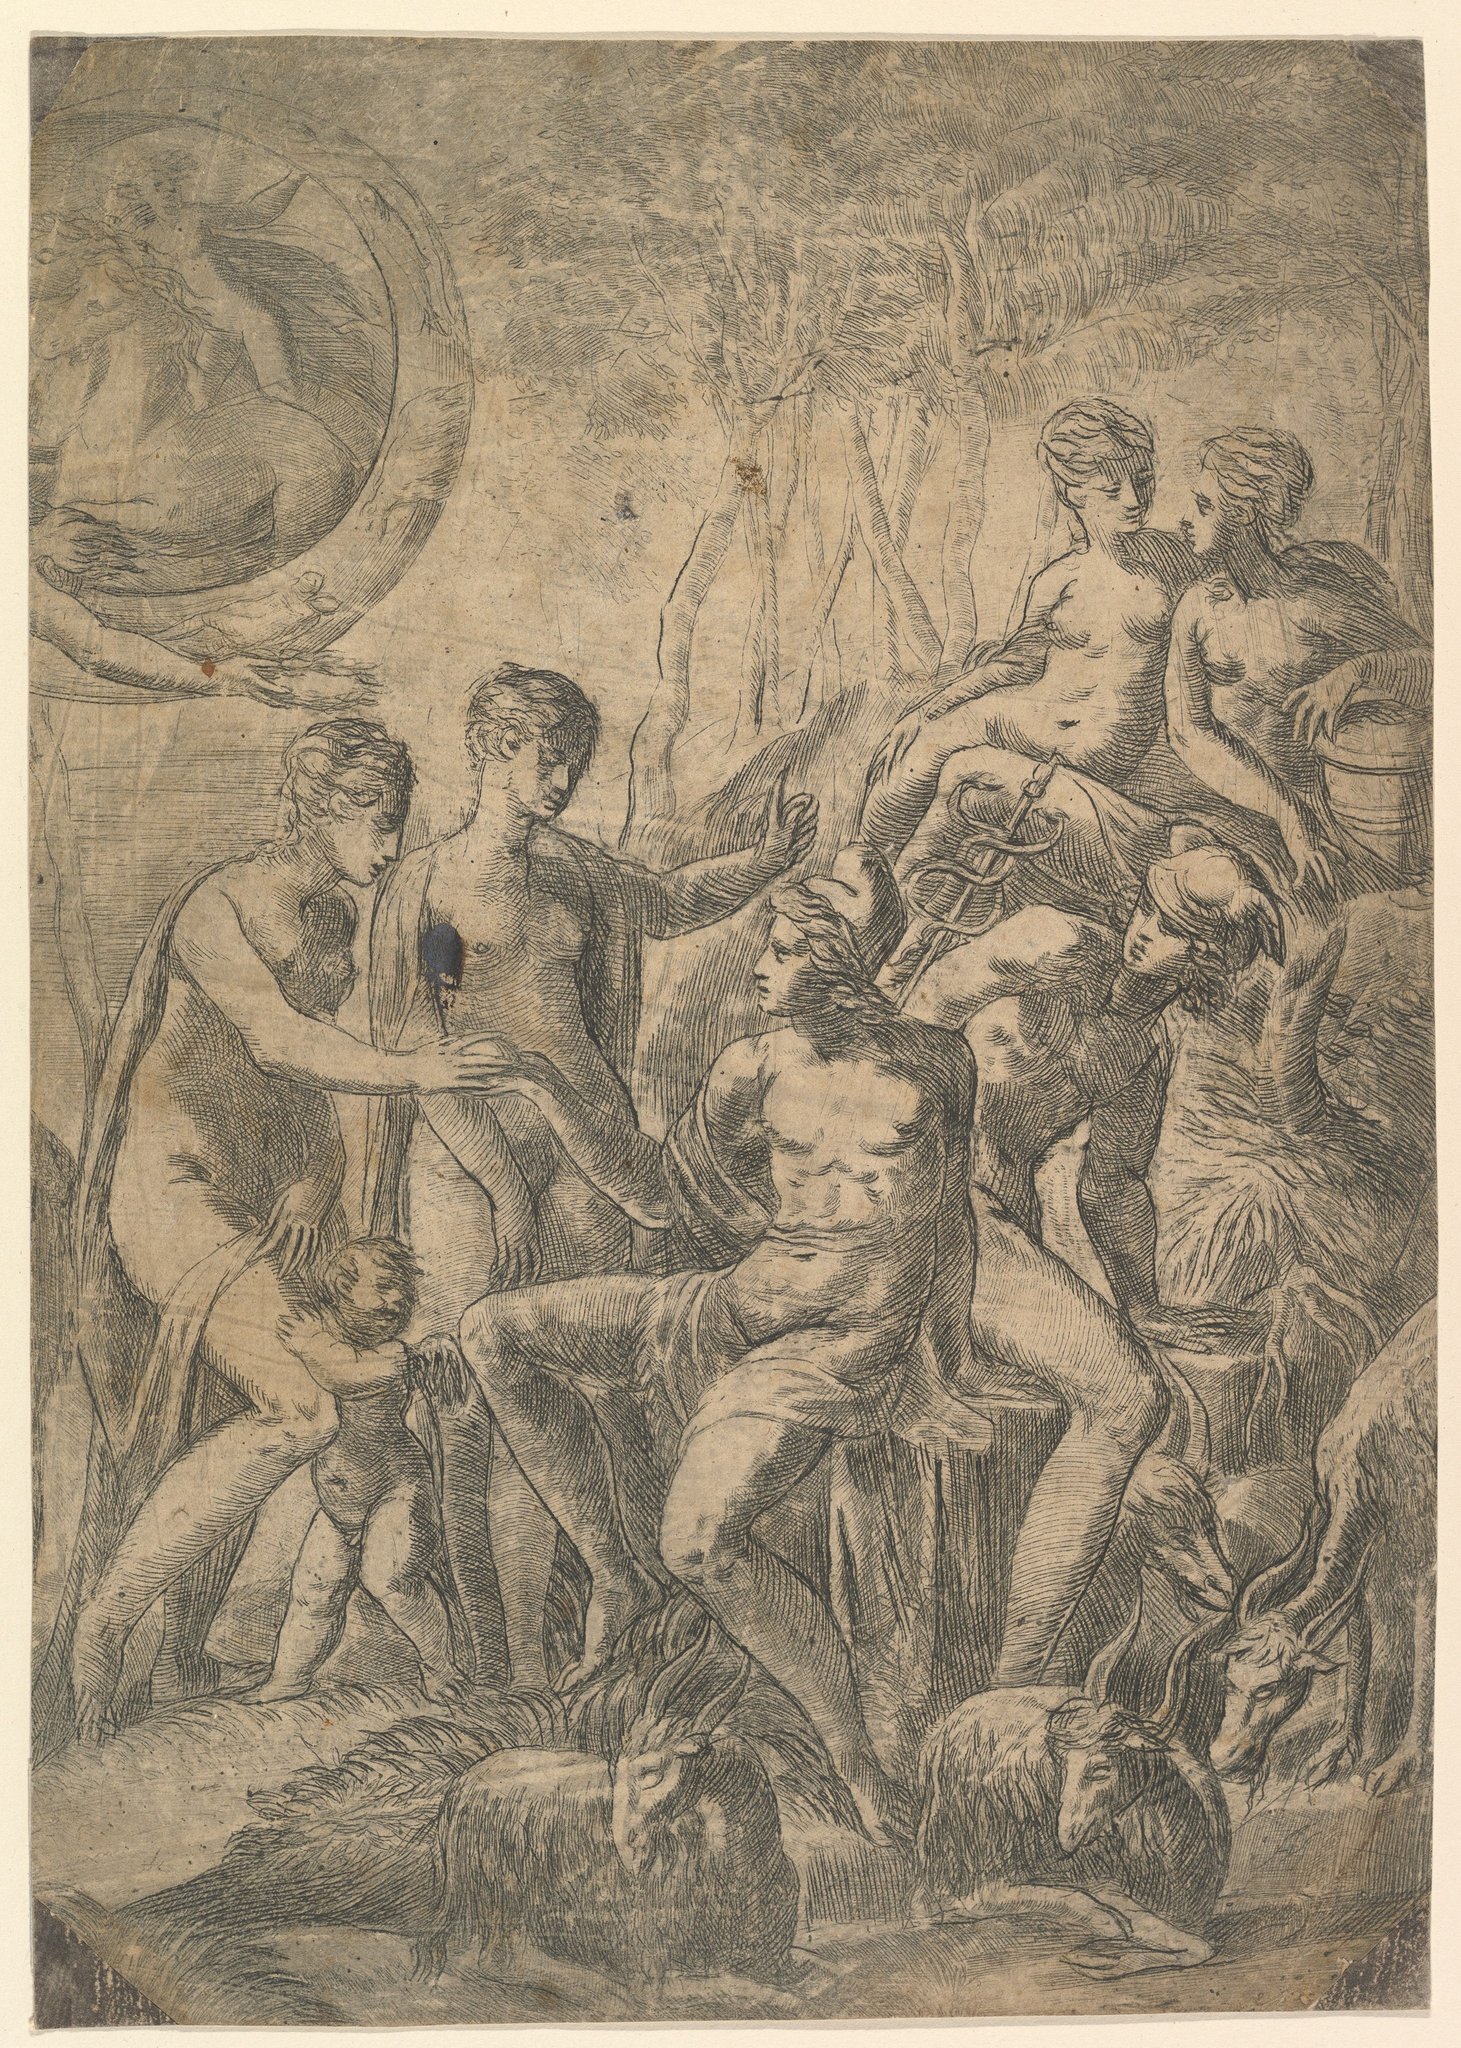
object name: print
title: The Judgment of Paris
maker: andrea schiavone (andrea meldola)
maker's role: artist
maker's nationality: italian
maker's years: 1510-1563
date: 1543-1546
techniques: etching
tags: children,male nudes,female nudes,goats